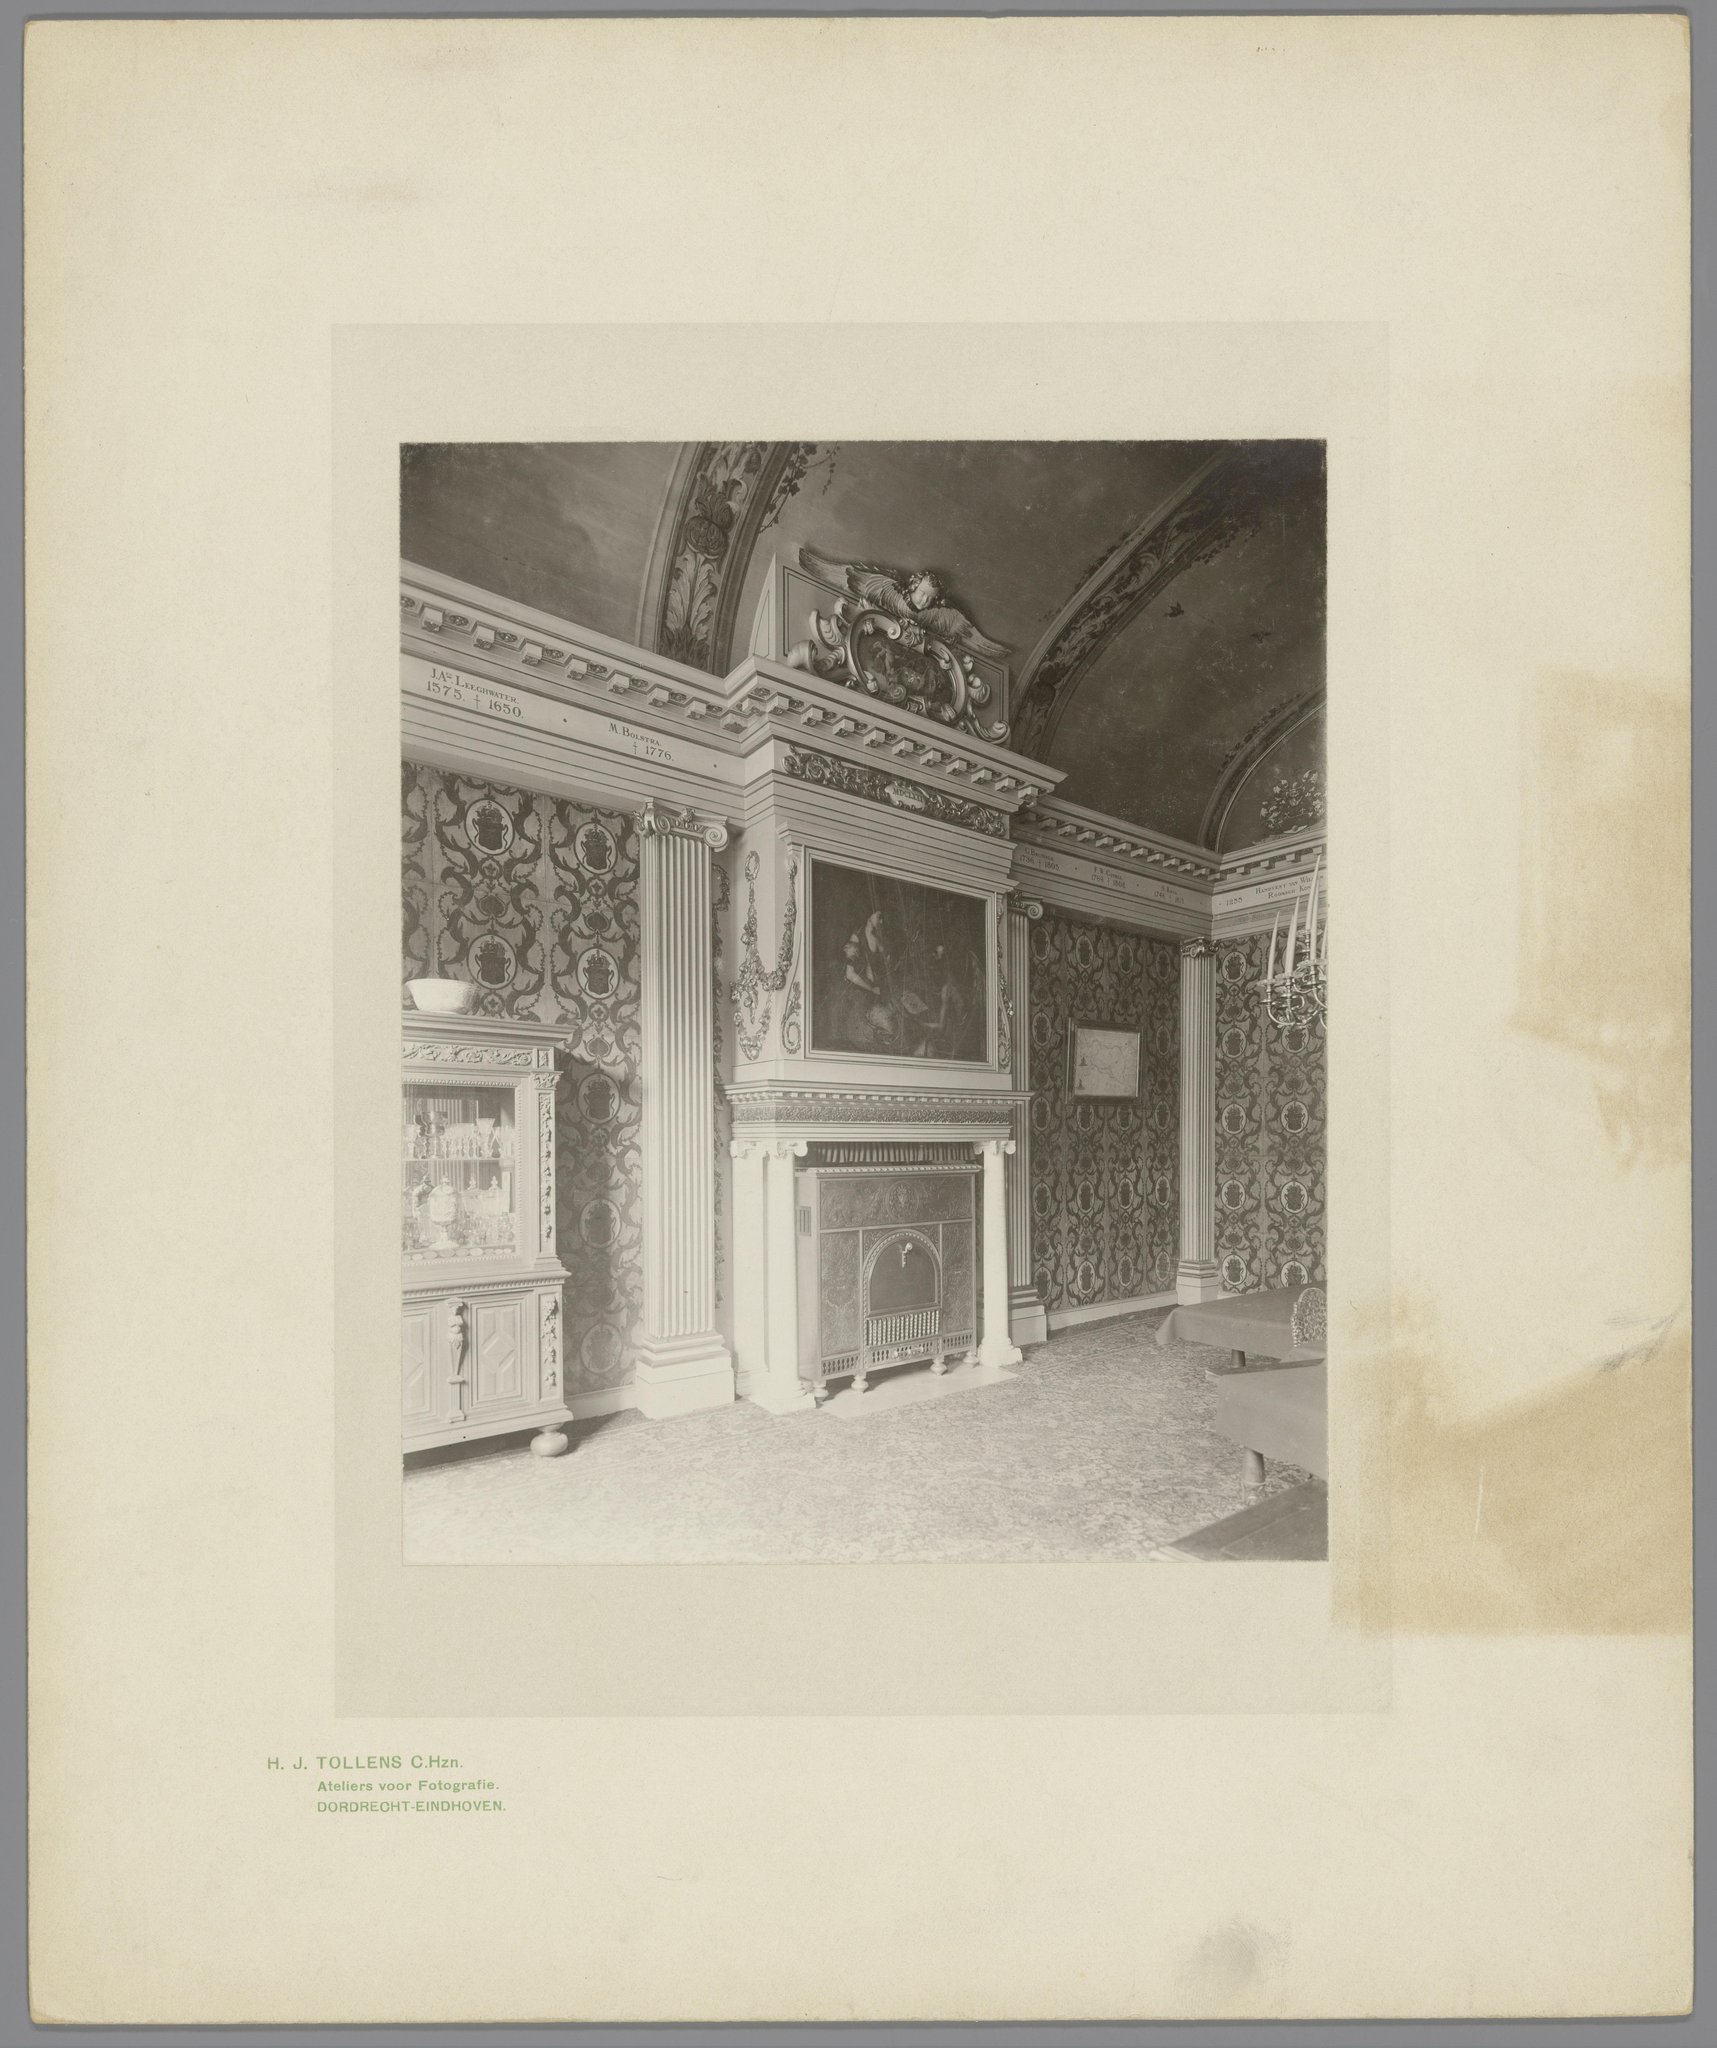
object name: photograph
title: Interieur van een kamer in het Rijnlandshuis te Leiden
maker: henricus jacobus tollens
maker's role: painter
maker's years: 1864-1936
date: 1880-1910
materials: cardboard, photographic support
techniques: collodion silver print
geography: leiden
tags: interior of the house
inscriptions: annotation: ‘Reynlandshuis te Leiden/ Reynlandshuis Leyde/ No.2’, inscription: ‘11[3]’, inscription: ‘H.J. Tollens C. Hzn./ Ateliers voor Fotografie/ Dordrecht-Eindhoven’